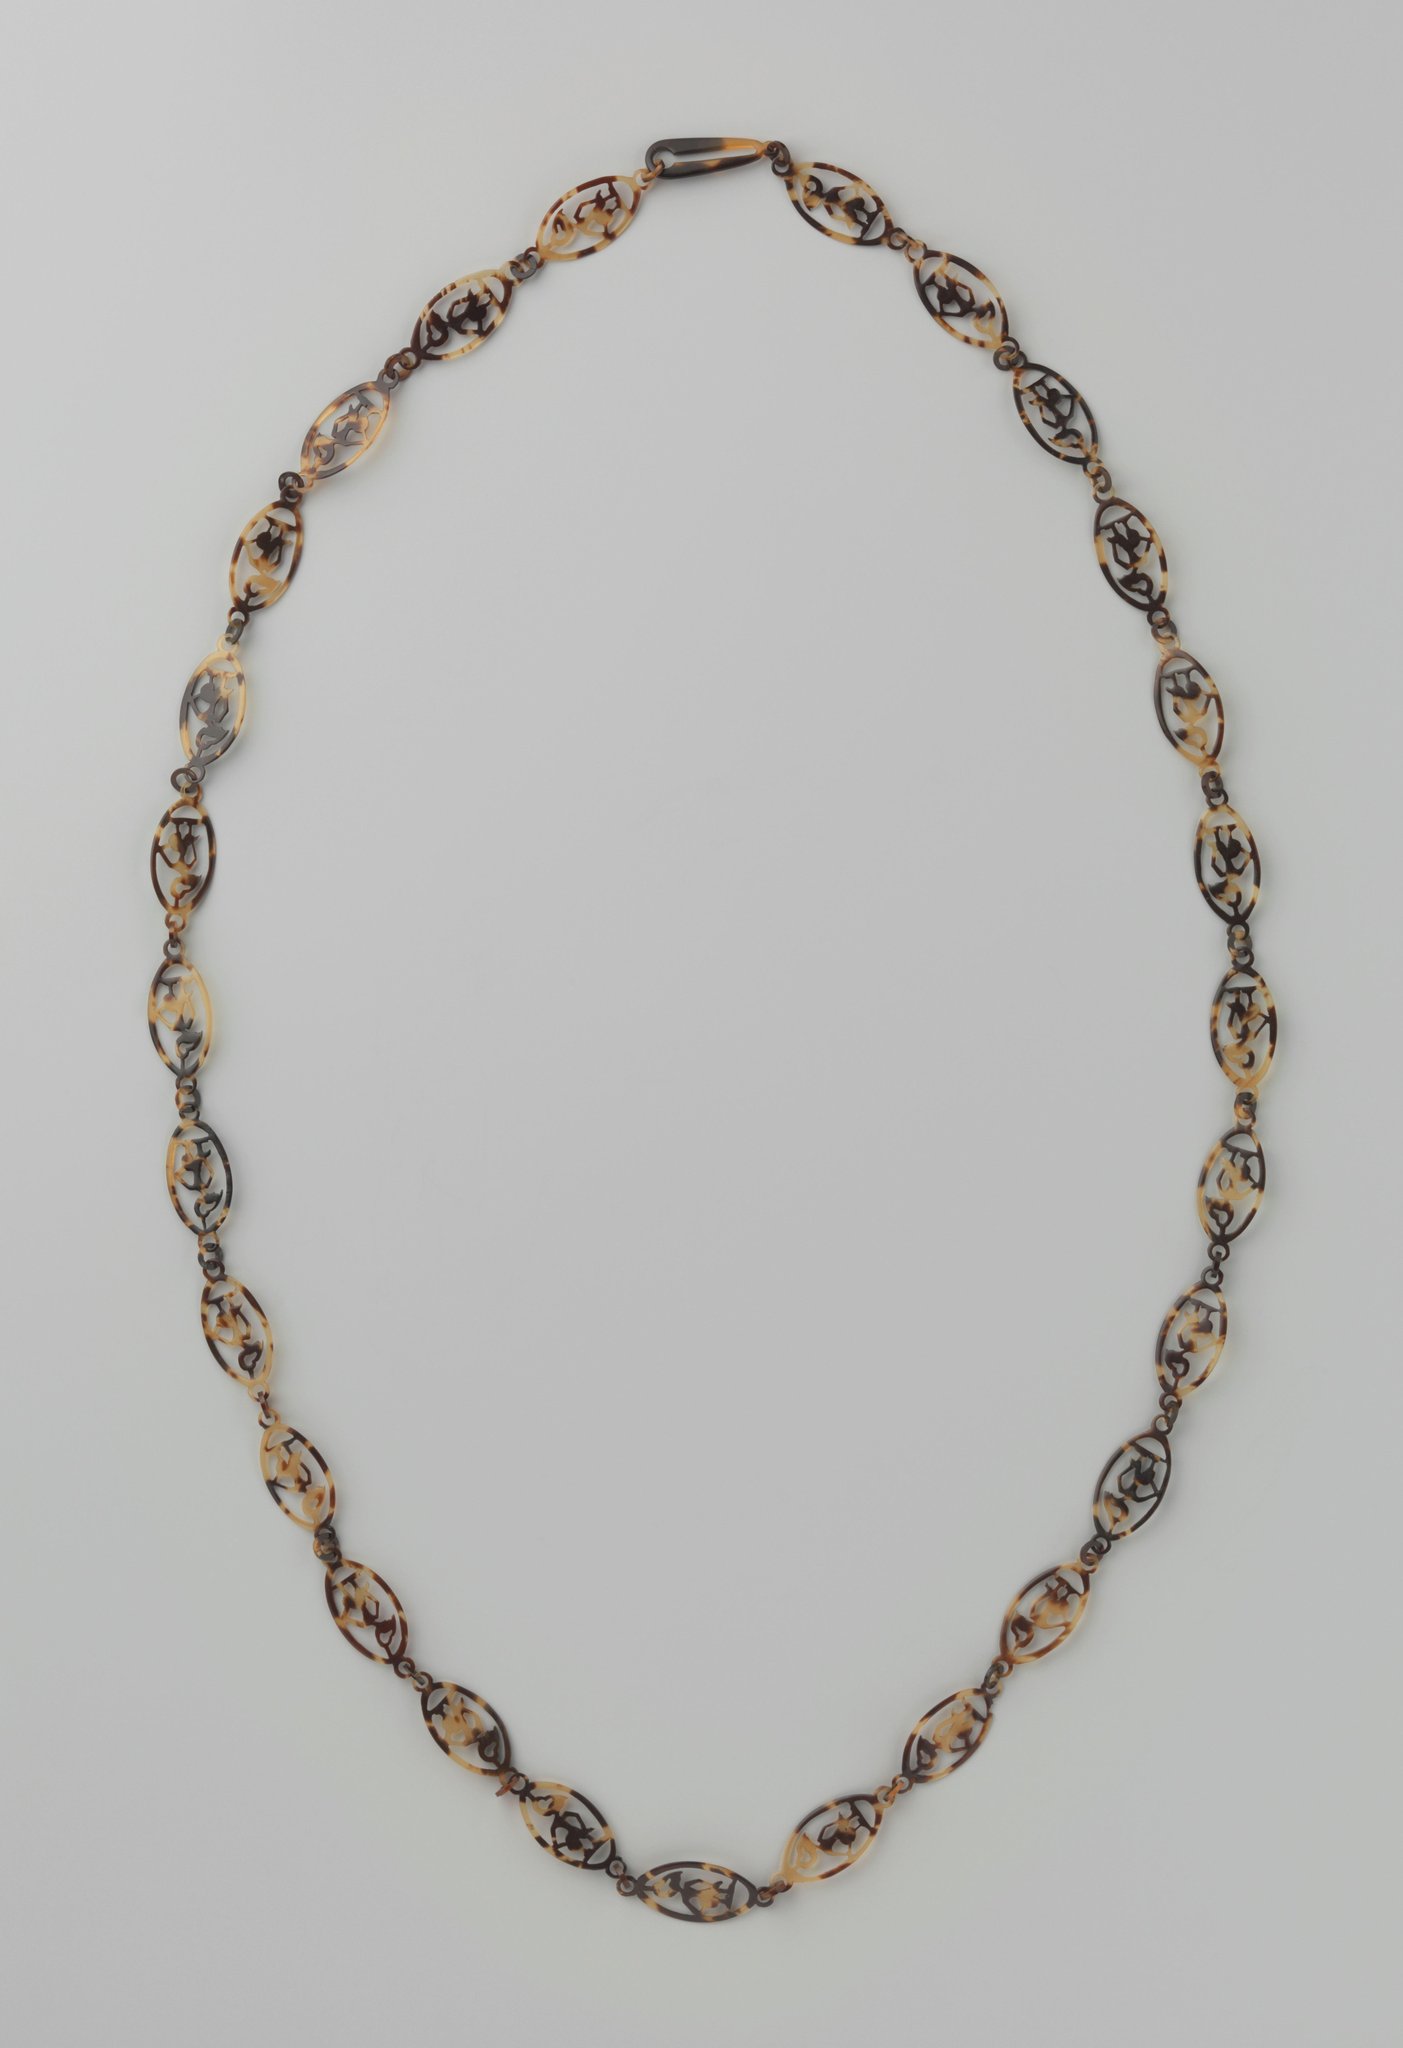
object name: necklace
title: Collier met schakels van wajangpoppen uitgesneden in imitatieschildpad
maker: willem van laar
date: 1930-1932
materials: tortoise shell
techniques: cutting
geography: netherlands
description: Collier met 27 schakels van wajangpoppen uitgesneden in imitatieschildpad.